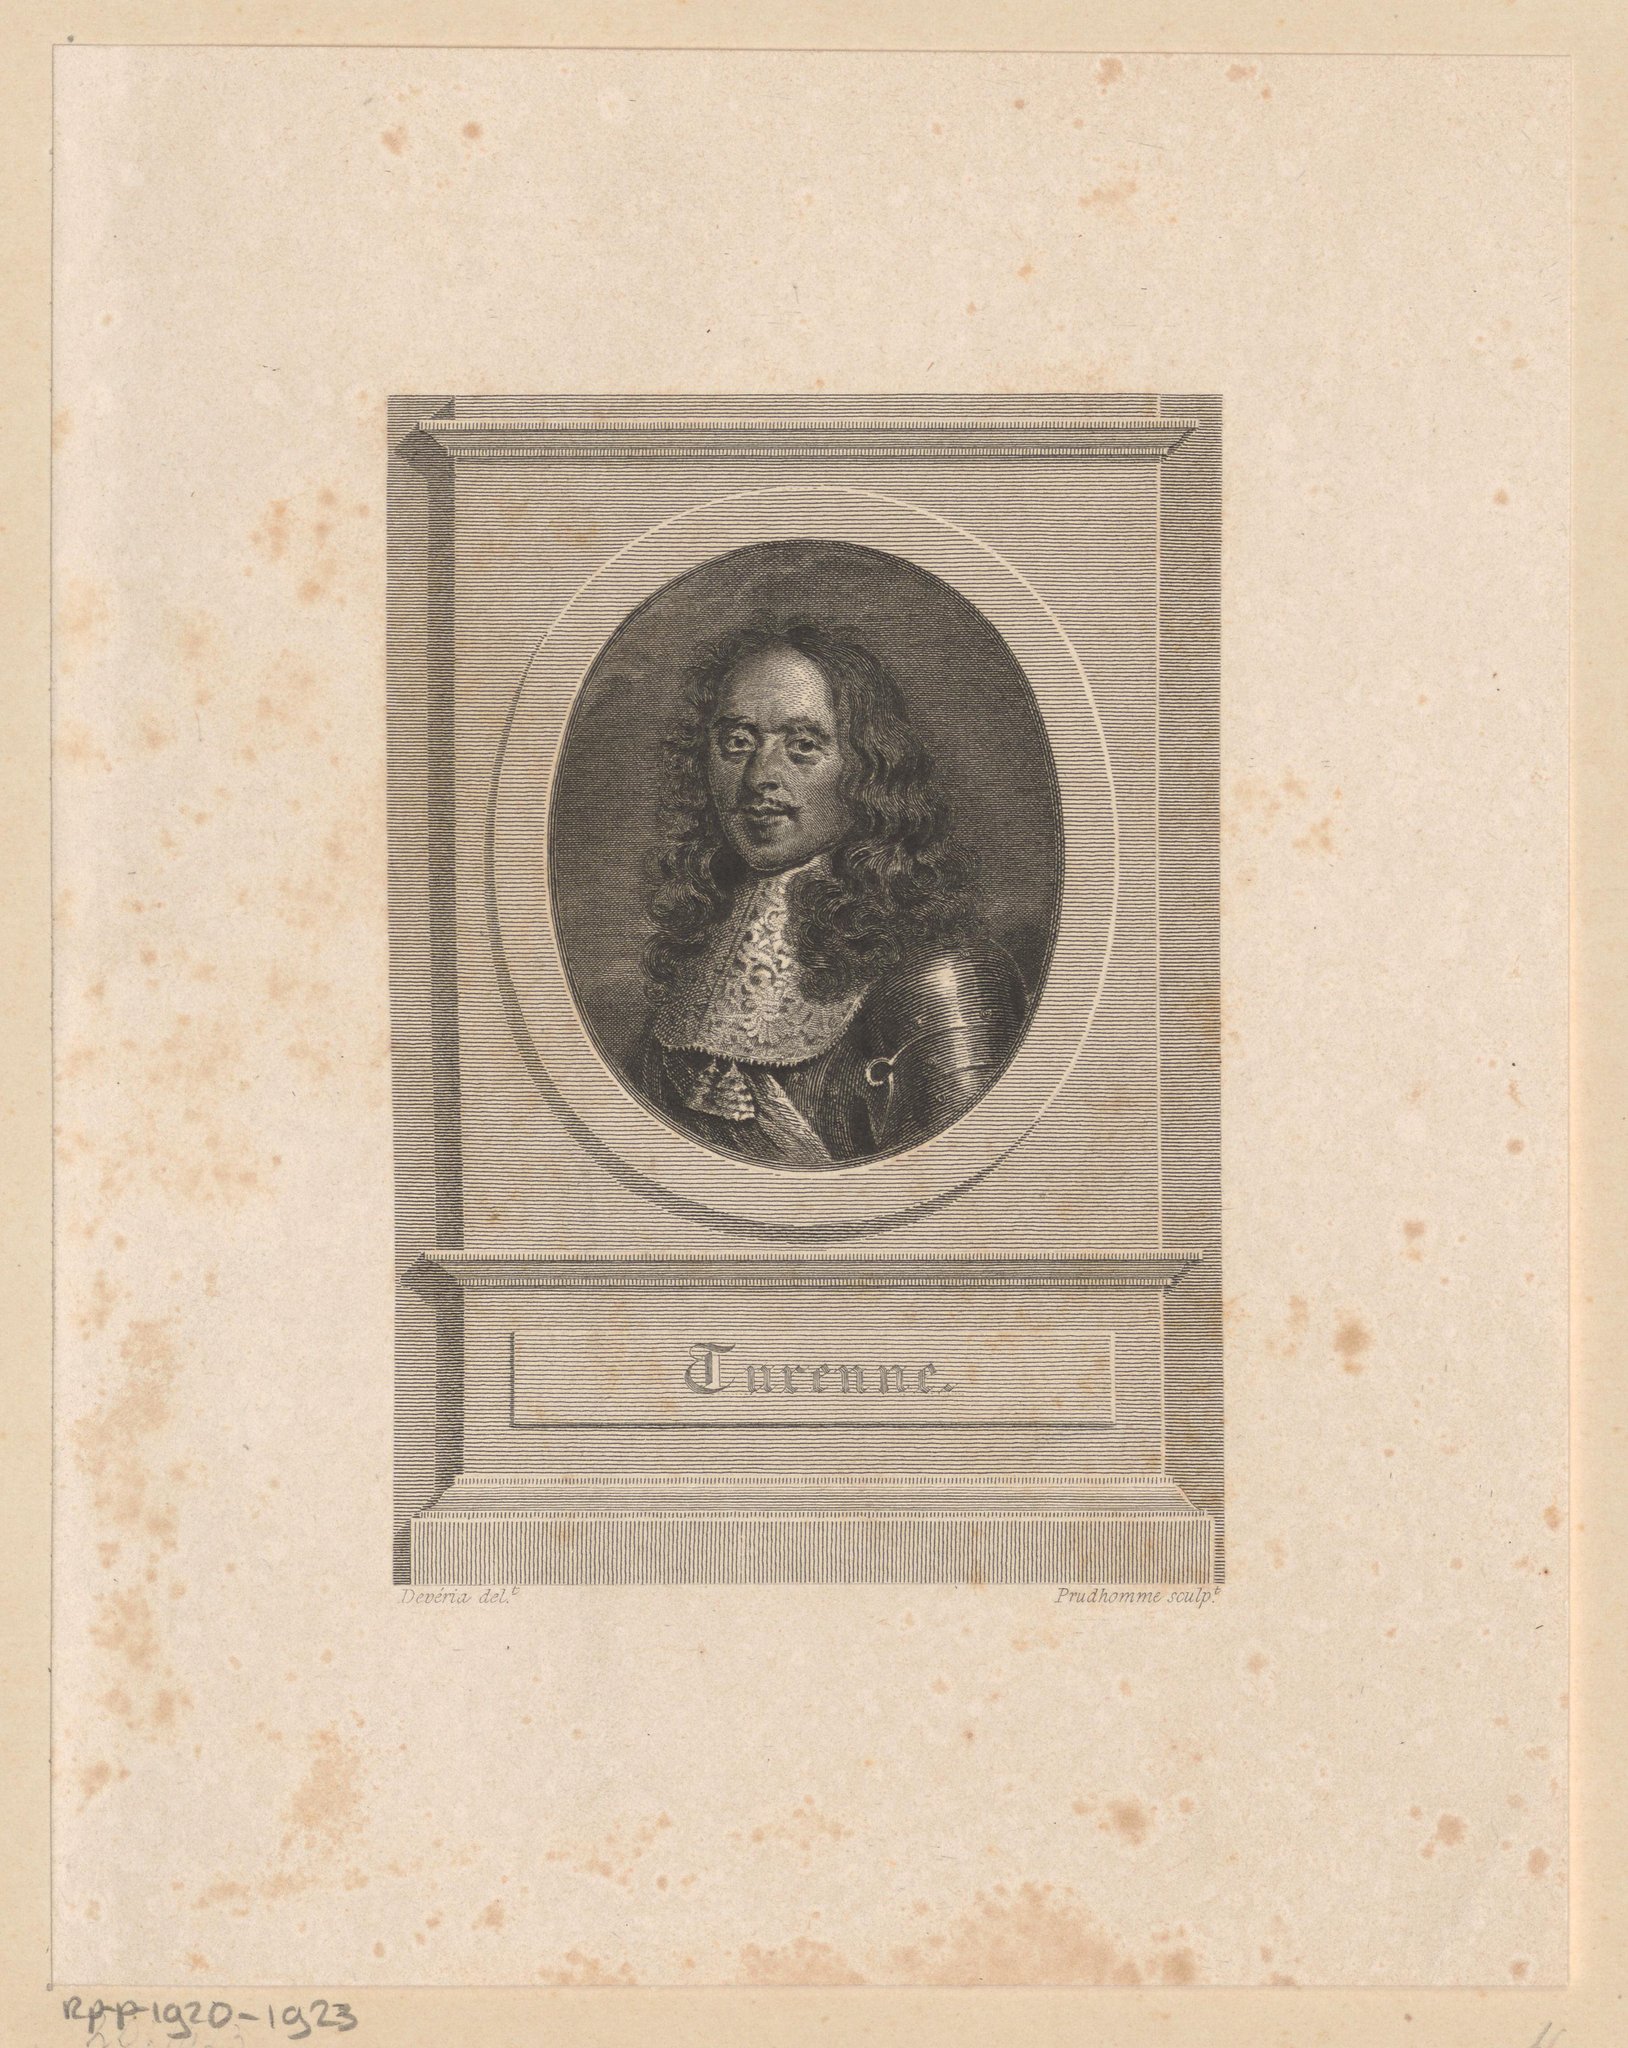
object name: print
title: Turenne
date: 1810-1853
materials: paper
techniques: engraving, etching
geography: paris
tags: commander-in-chief, general, marshal, armour, historical persons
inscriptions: collector's mark: Lugt 2228